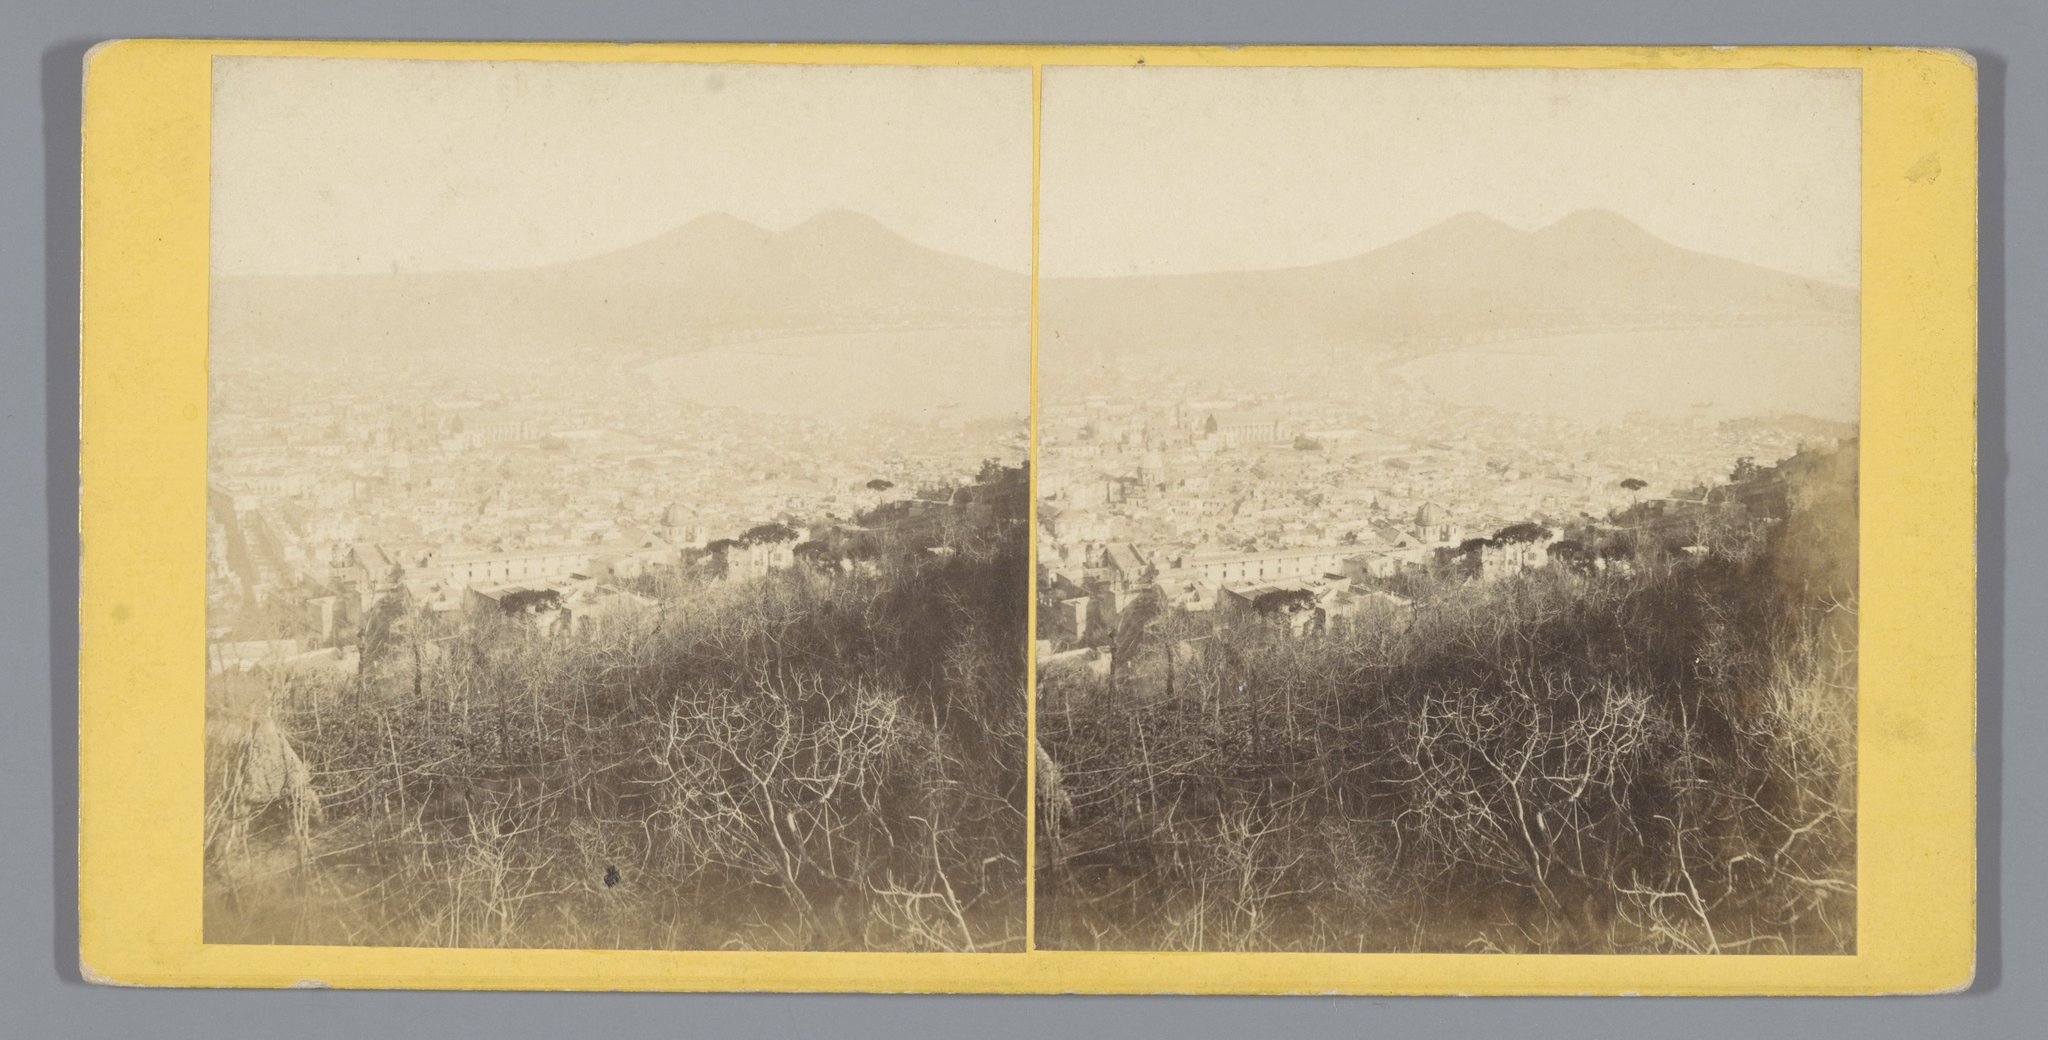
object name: stereograph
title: Vue générale prise de Saint-Elme (Naples).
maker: Anonymous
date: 1850-1880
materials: cardboard, photographic support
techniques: albumen print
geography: castel sant'elmo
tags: city-view in general; 'veduta', naples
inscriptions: number: ‘758.’, inscription: ‘DBR’